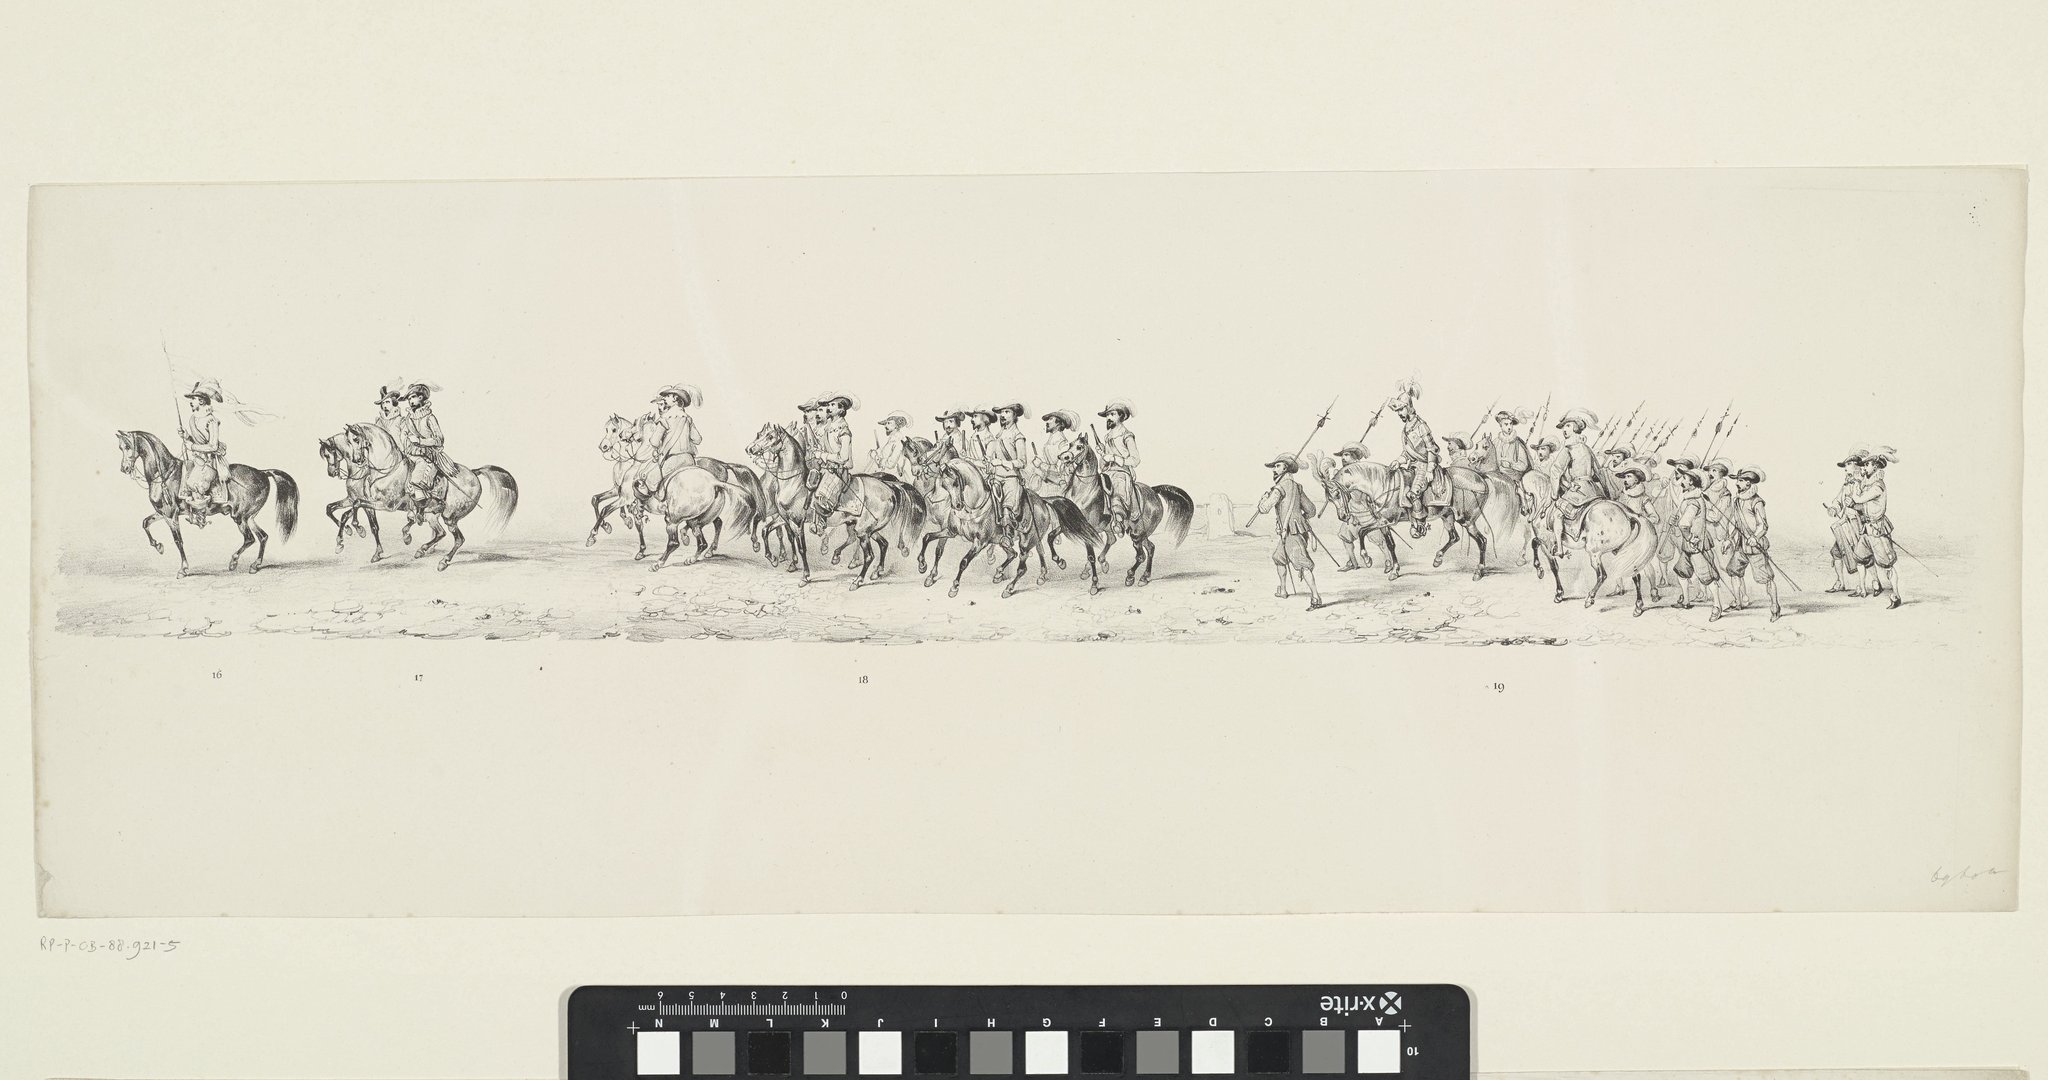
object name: print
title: Historische optocht bij het tweede eeuwfeest van de Utrechtse Hogeschool, 1836 (plaat 5)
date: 1837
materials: paper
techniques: lithograph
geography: rotterdam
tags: students' pageant, costumes used in pageants, battle of nieuwpoort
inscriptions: collector's mark: Lugt 2228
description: Historische gekostumeerde optocht van de studenten van de Hogeschool van Utrecht op 16 juni 1836, bij de viering van het tweede eeuwfeest van de Utrechtse Hogeschool. De optocht verbeeldt de intocht van het Staatse leger in Oostende op 3 juli 1600, daags na de overwinning in de Slag bij Nieuwpoort. Vijfde plaat in een serie van tien ongenummerde platen, met de groepen genummerd 16-19.